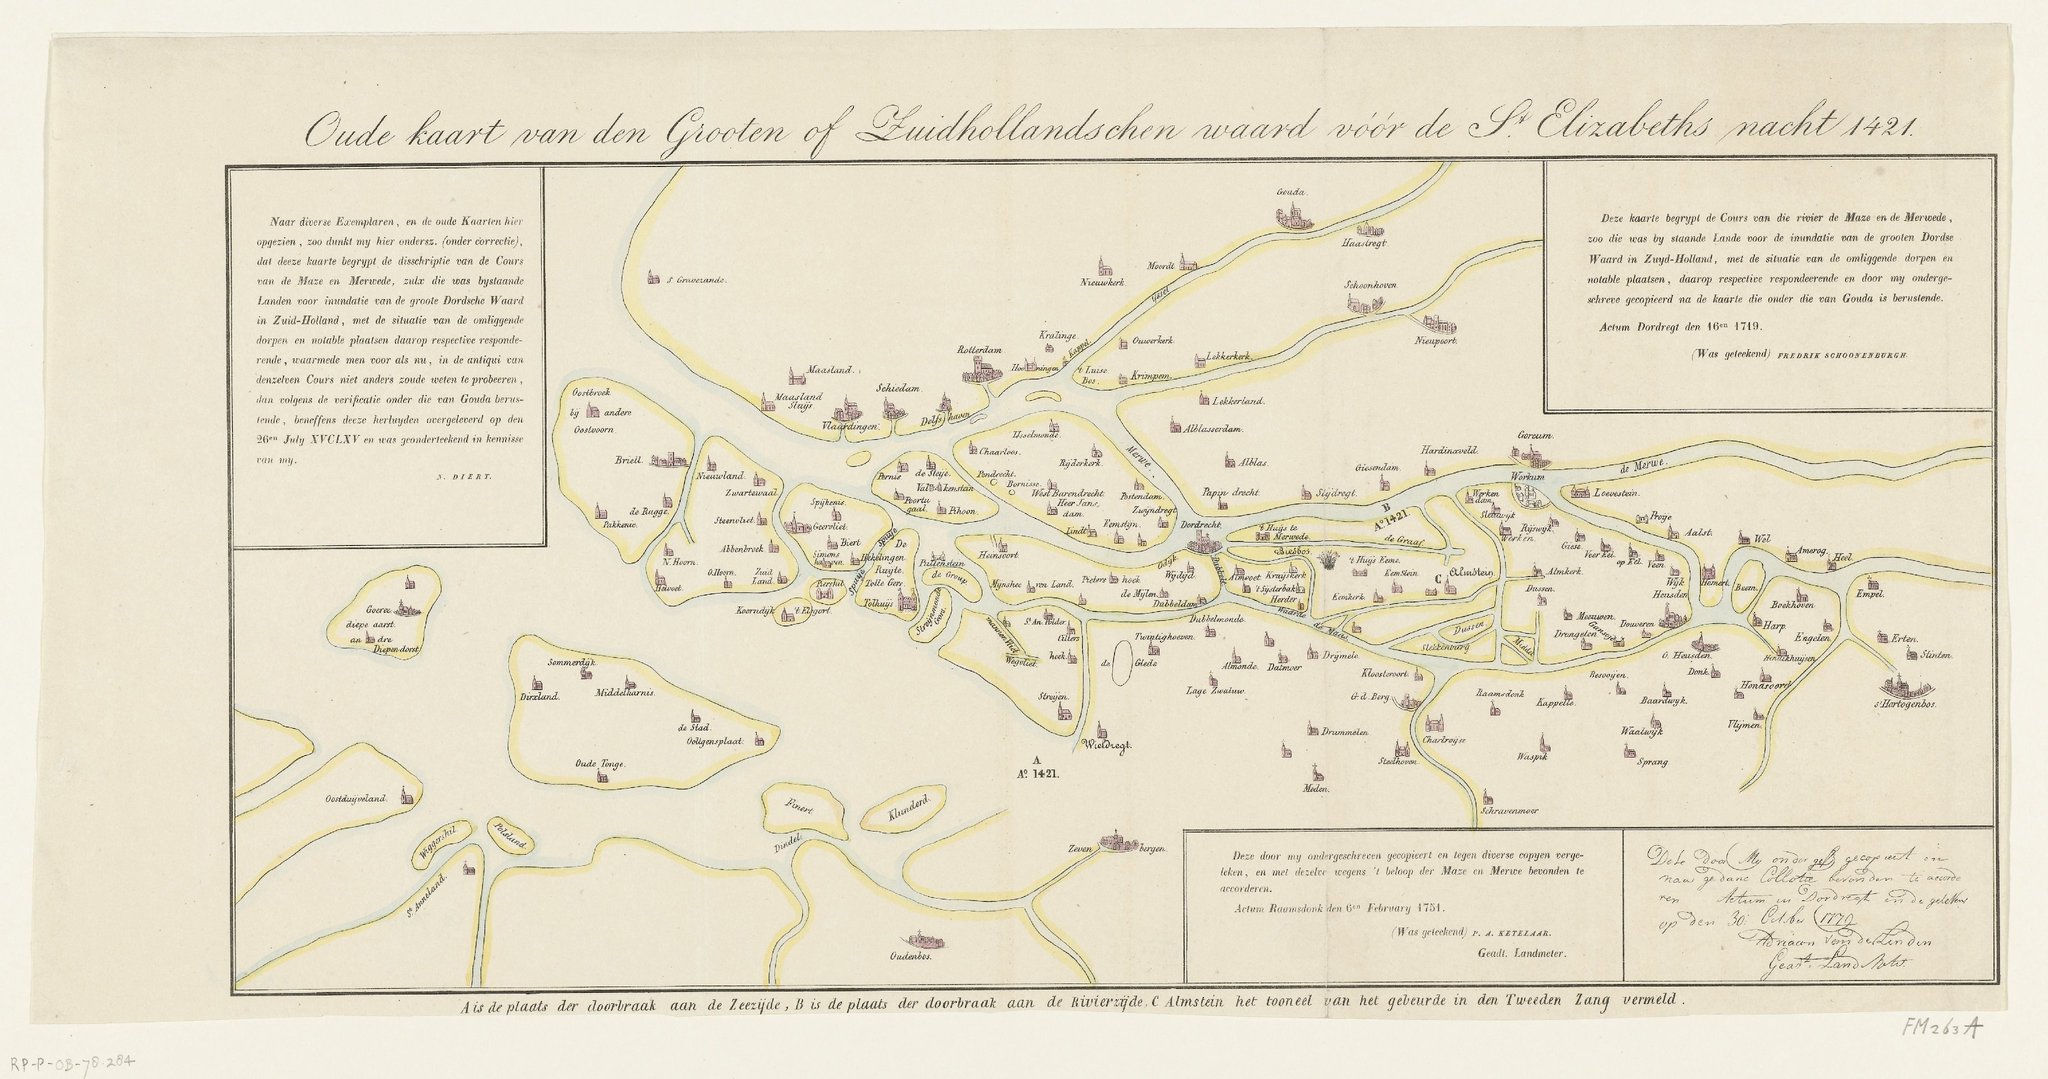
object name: print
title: Oude kaart van Zuid-Hollandsche Waard vóór de Sint Elisabethsvloed van 1421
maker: Anonymous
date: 1800-1899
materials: paper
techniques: hand coloring, lithograph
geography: netherlands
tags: maps of separate countries or regions, flood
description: Oude kaart van Zuid-Hollandsche Waard vóór de Sint Elisabethsvloed van 19 november 1421.